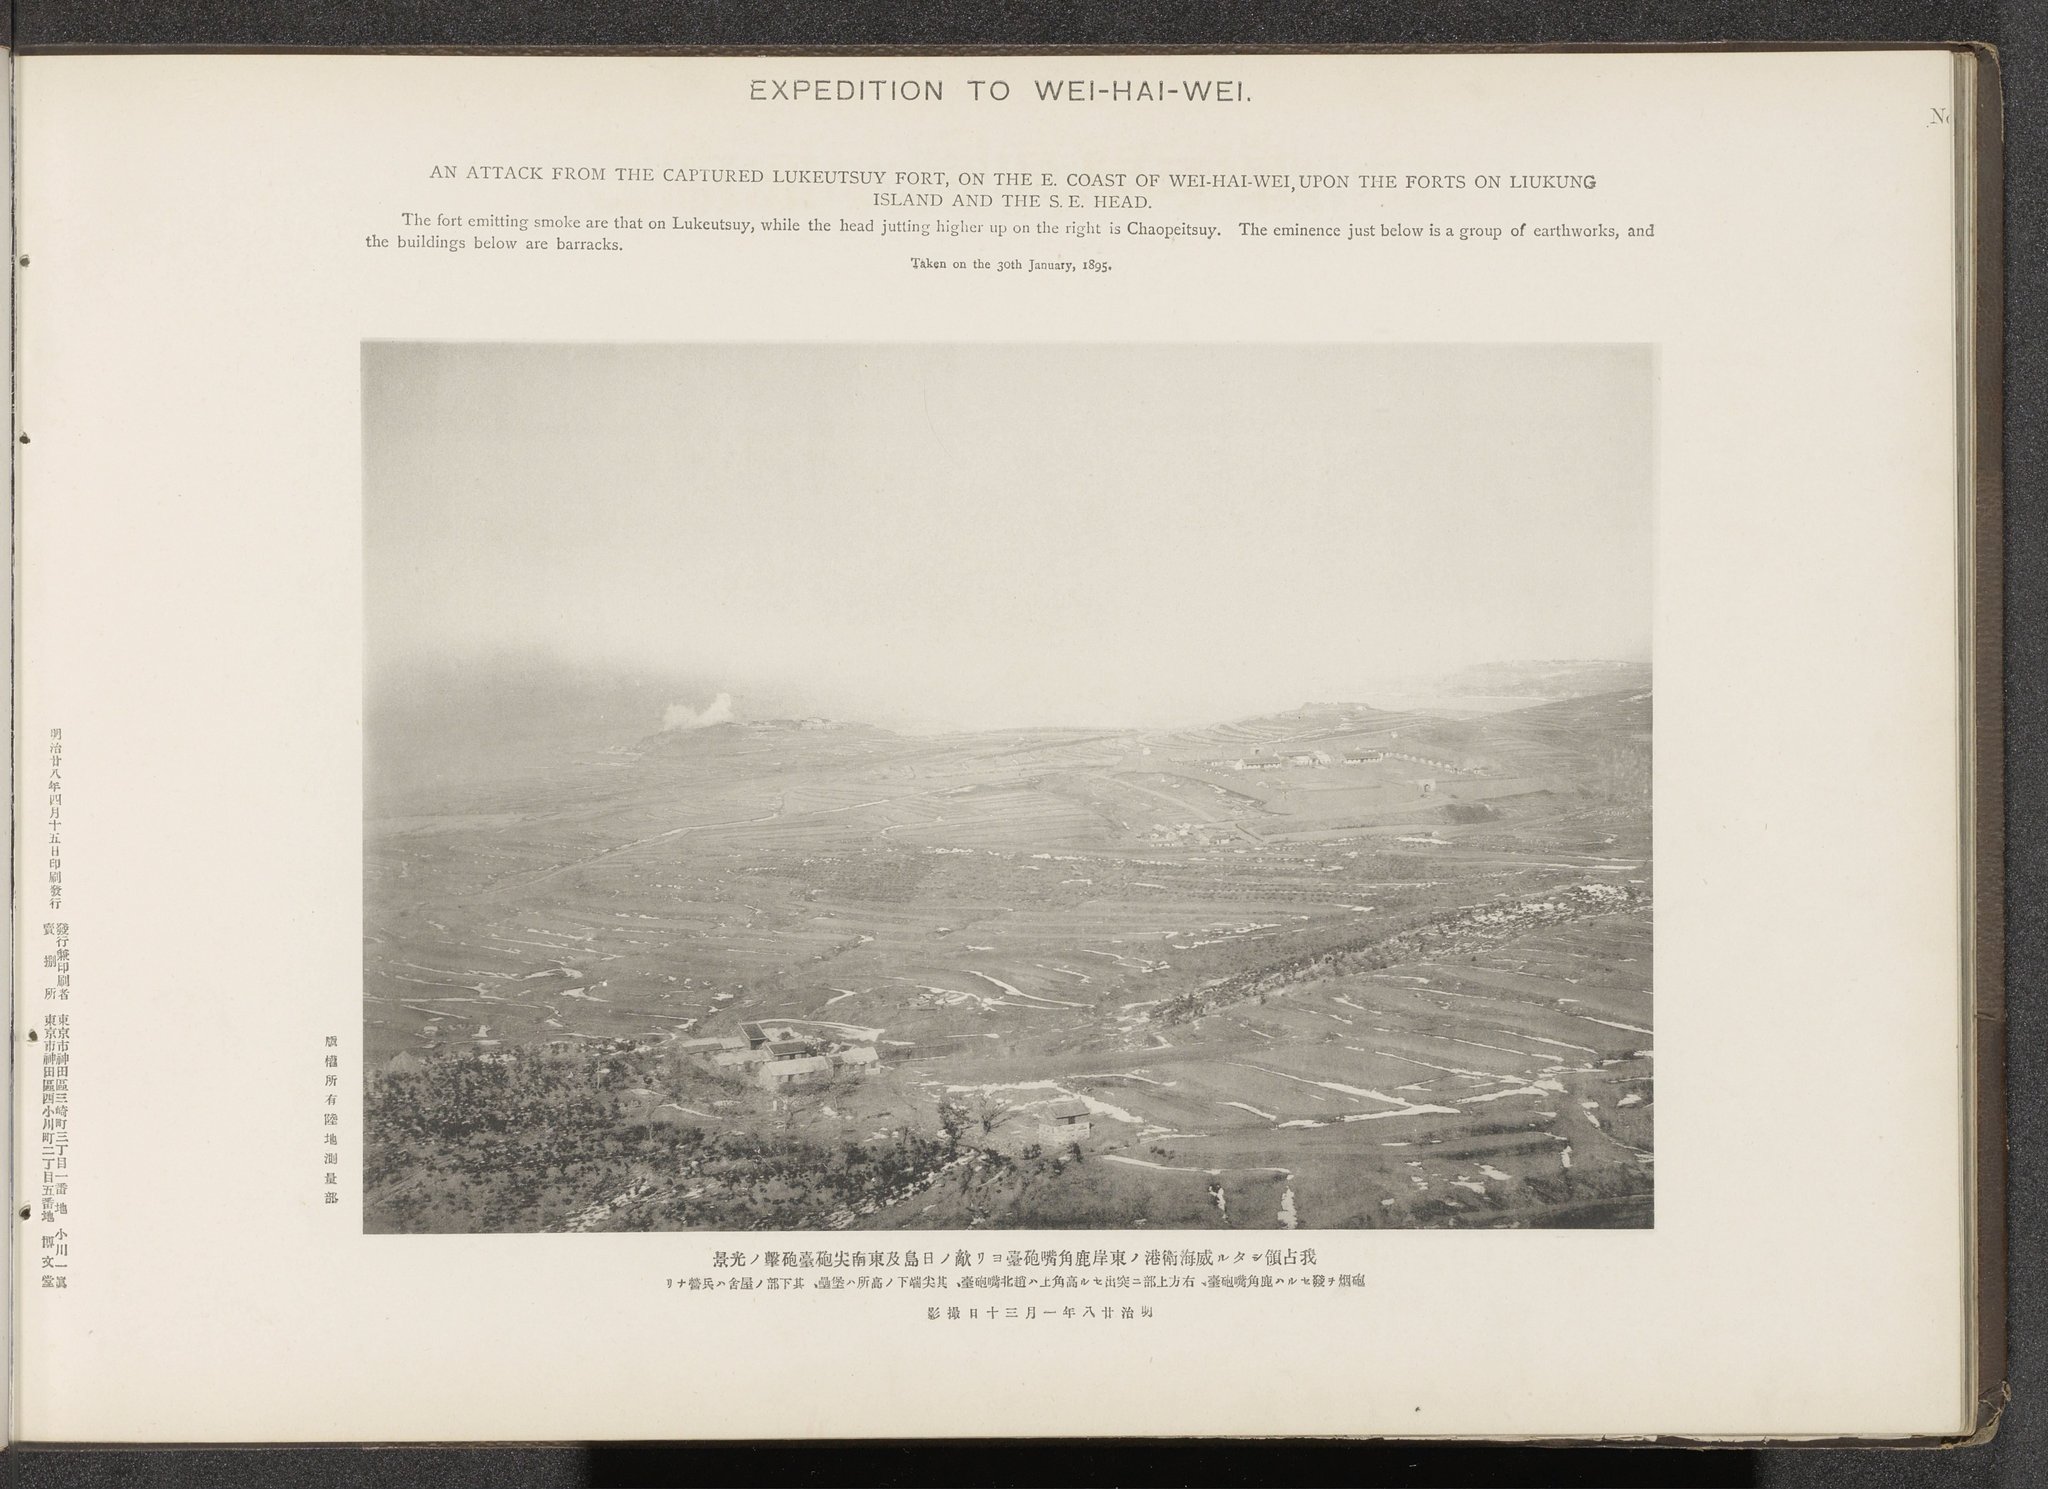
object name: photomechanical print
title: An attack from the captured Lukeutsuy fort, on the E. coast of Wei-Hai-Wei, upon the forts on Liukung Island and the S. E. head.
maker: kazumasa ogawa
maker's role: auteur, fotograaf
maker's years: 1860-1929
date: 1895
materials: paper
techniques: photograph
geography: japan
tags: fortress, (military) attack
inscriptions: inscription: ‘Expedition to Wei-Hai-Wei.’, inscription: ‘The fort emitting smoke (...) the buildings below are barracks.’